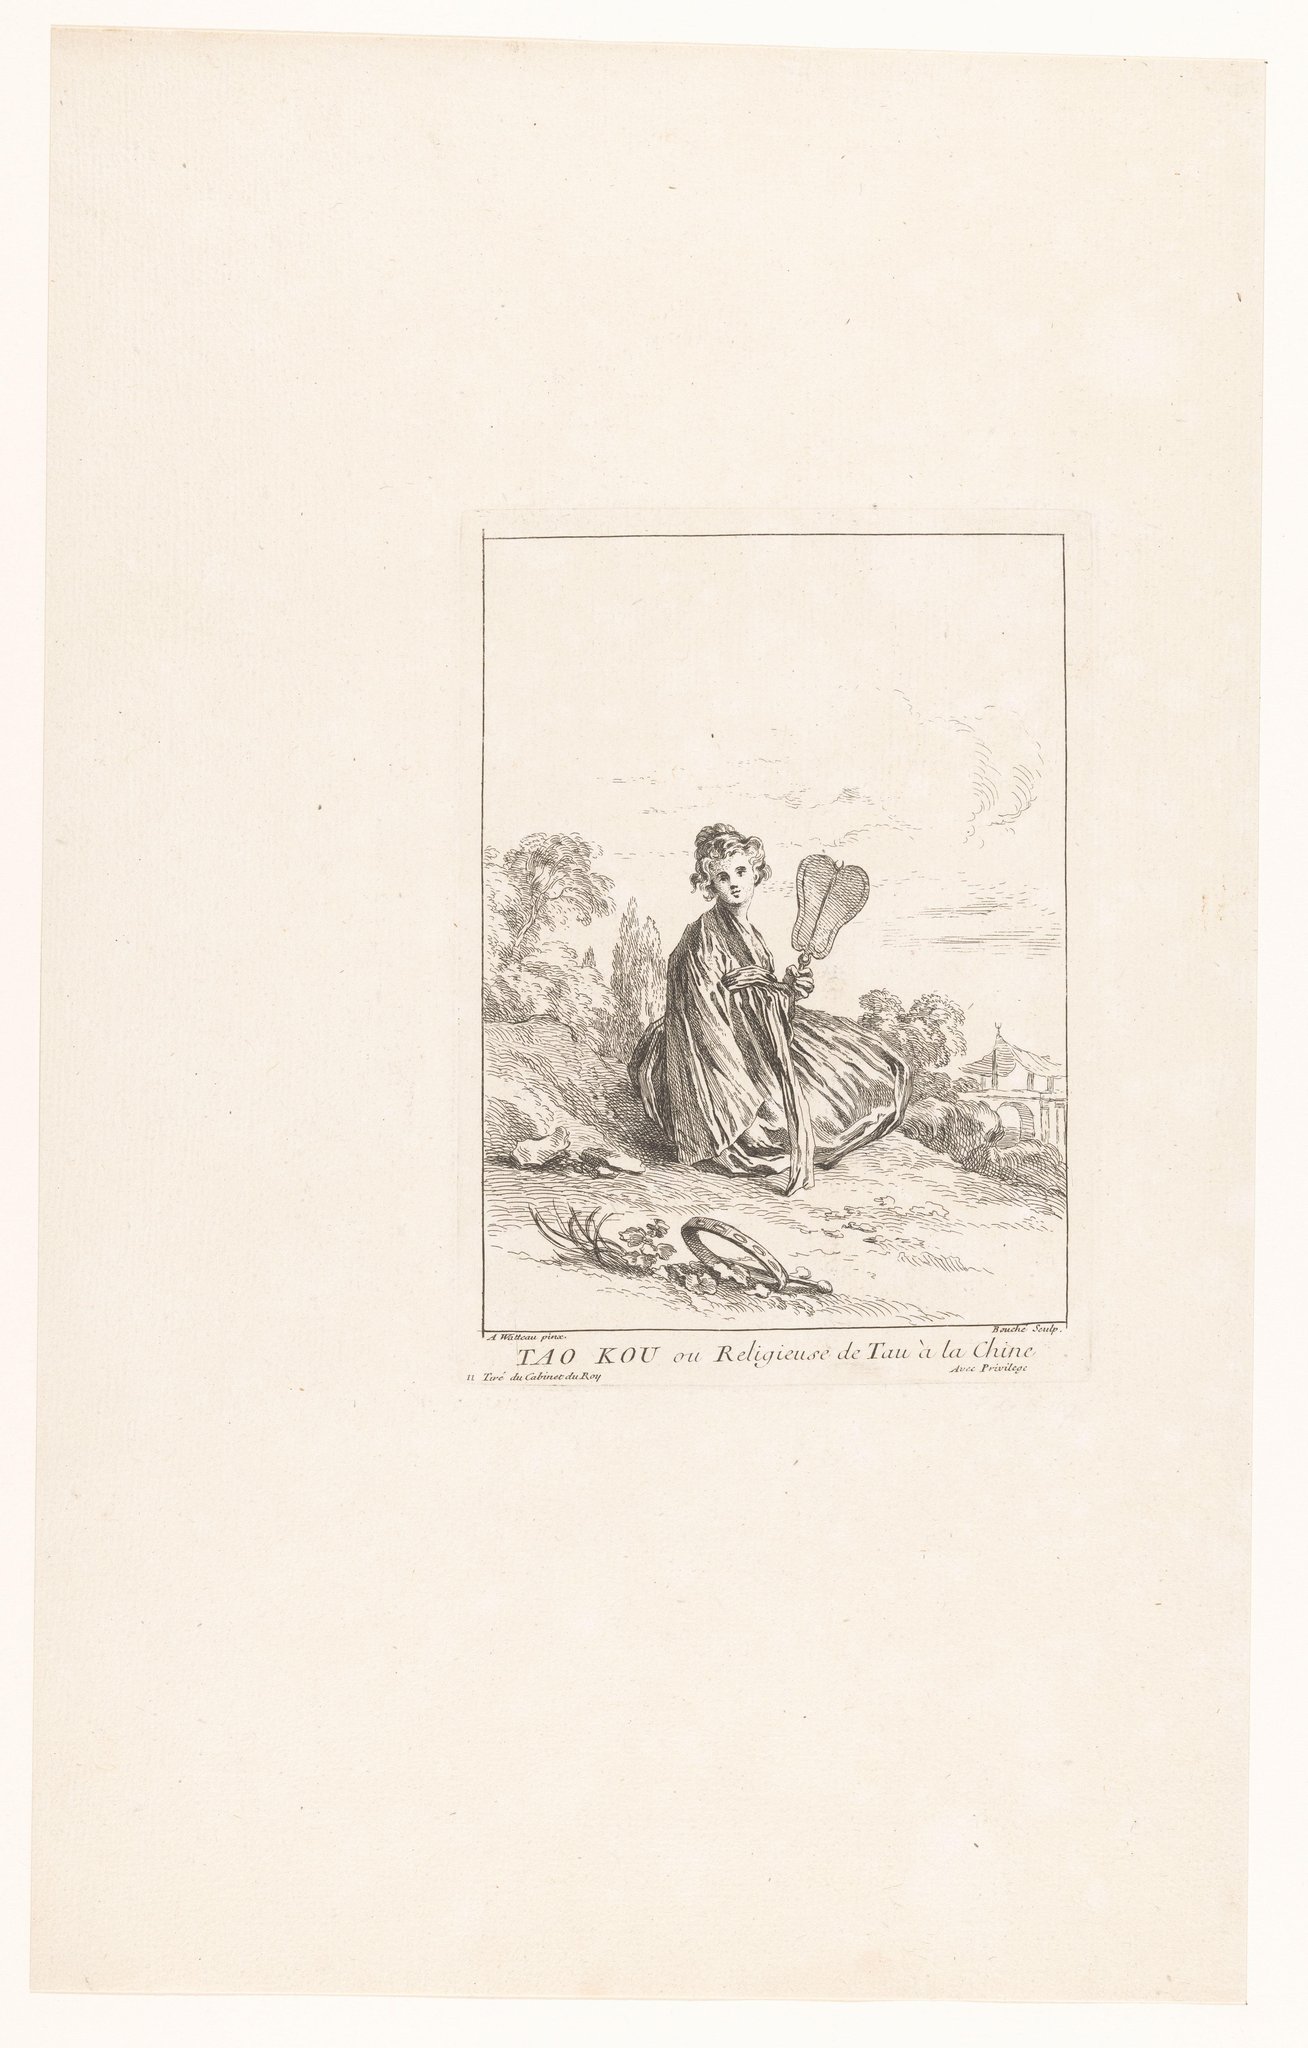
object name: print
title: Oeuvre van Antoine Watteau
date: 1731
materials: paper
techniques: etching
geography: paris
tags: adolescent, young woman, maiden, chinese, nun(s), sitting on the ground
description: Maakt deel uit van een serie van 271 platen, inclusief twee titelprenten, naar schilderijen door Watteau en verzameld door Jean de Jullienne. Sommige platen werden reeds tijdens Watteau's leven vervaardigd en de rest kwam pas na zijn dood tot stand. In 1734 werd het eind van de serie aangekondigd. Deze plaat betreft nr. 246 van de serie. Maakt eveneens deel uit van een subgroep van twaalf prenten, getiteld 'Diverses Figures Chinoises et Tartares Peintes par Watteau (...)'.